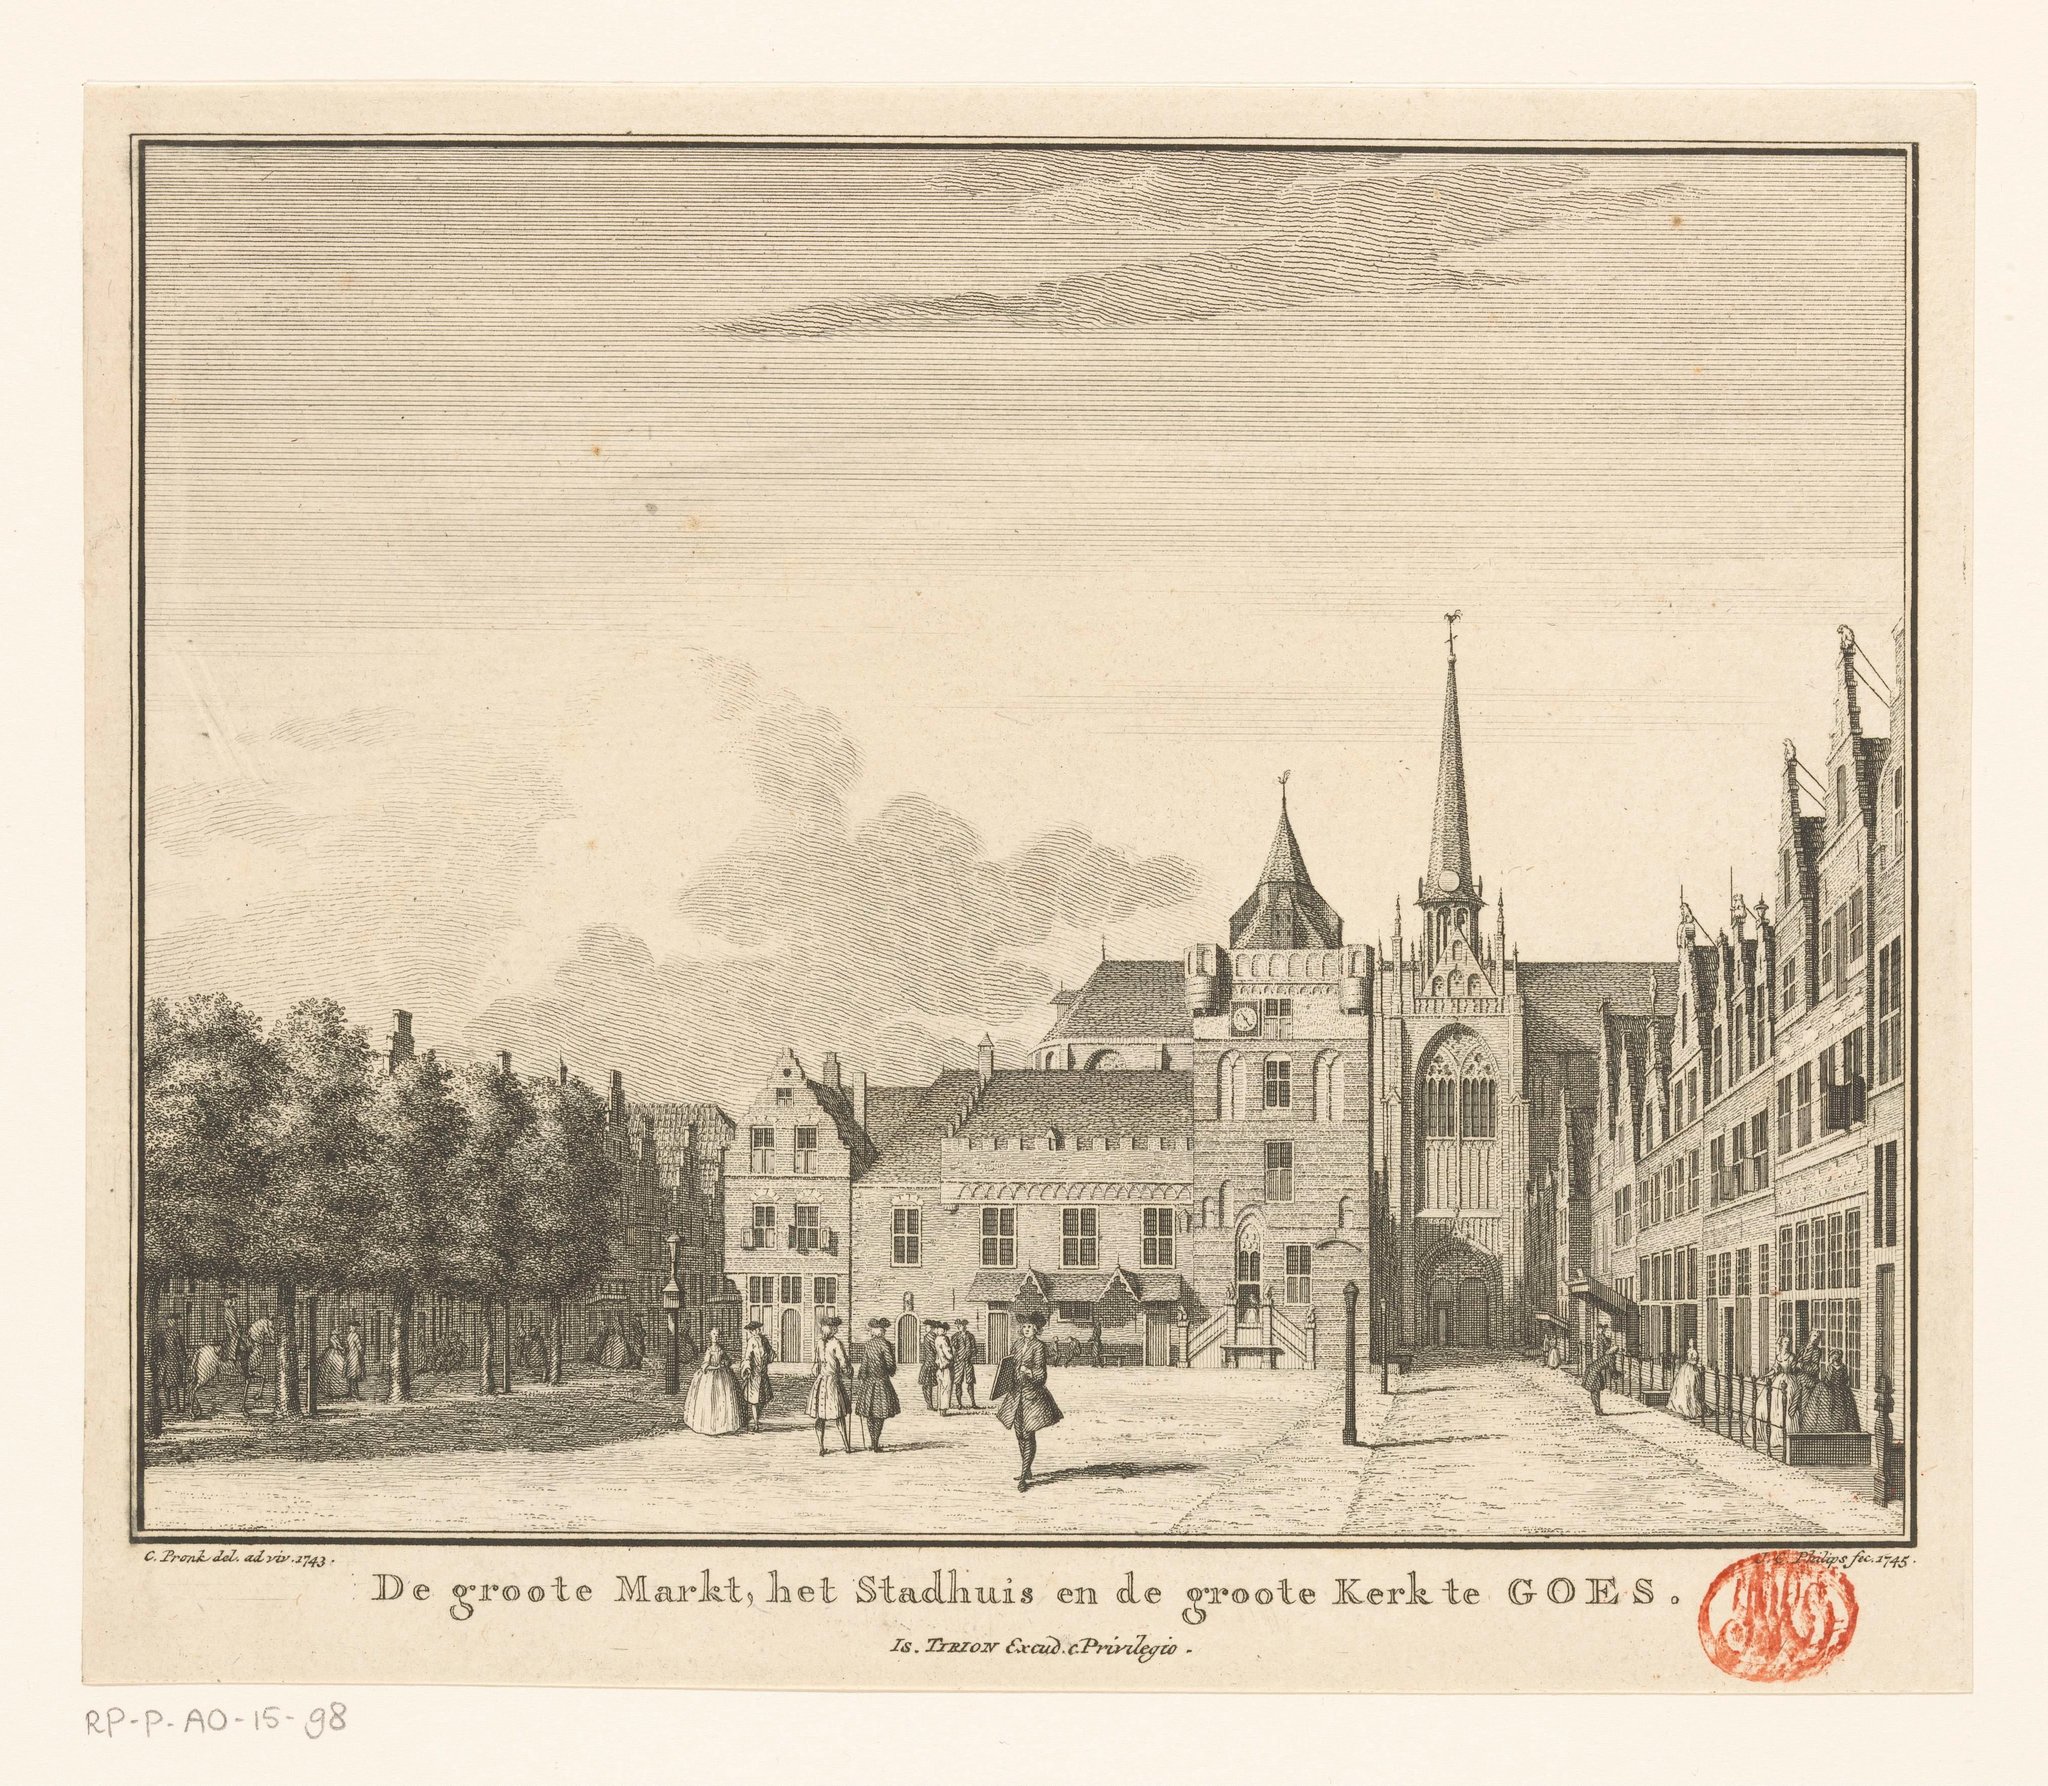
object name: book illustration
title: De groote Markt, het stadhuis en de groote Kerk te Goes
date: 1745-1760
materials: paper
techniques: etching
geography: amsterdam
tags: church (exterior), townhall, market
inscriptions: collector's mark: Lugt 195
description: Gezicht op de Grote Markt, het stadhuis en de Grote Kerk te Goes, in de situatie omstreeks 1743.